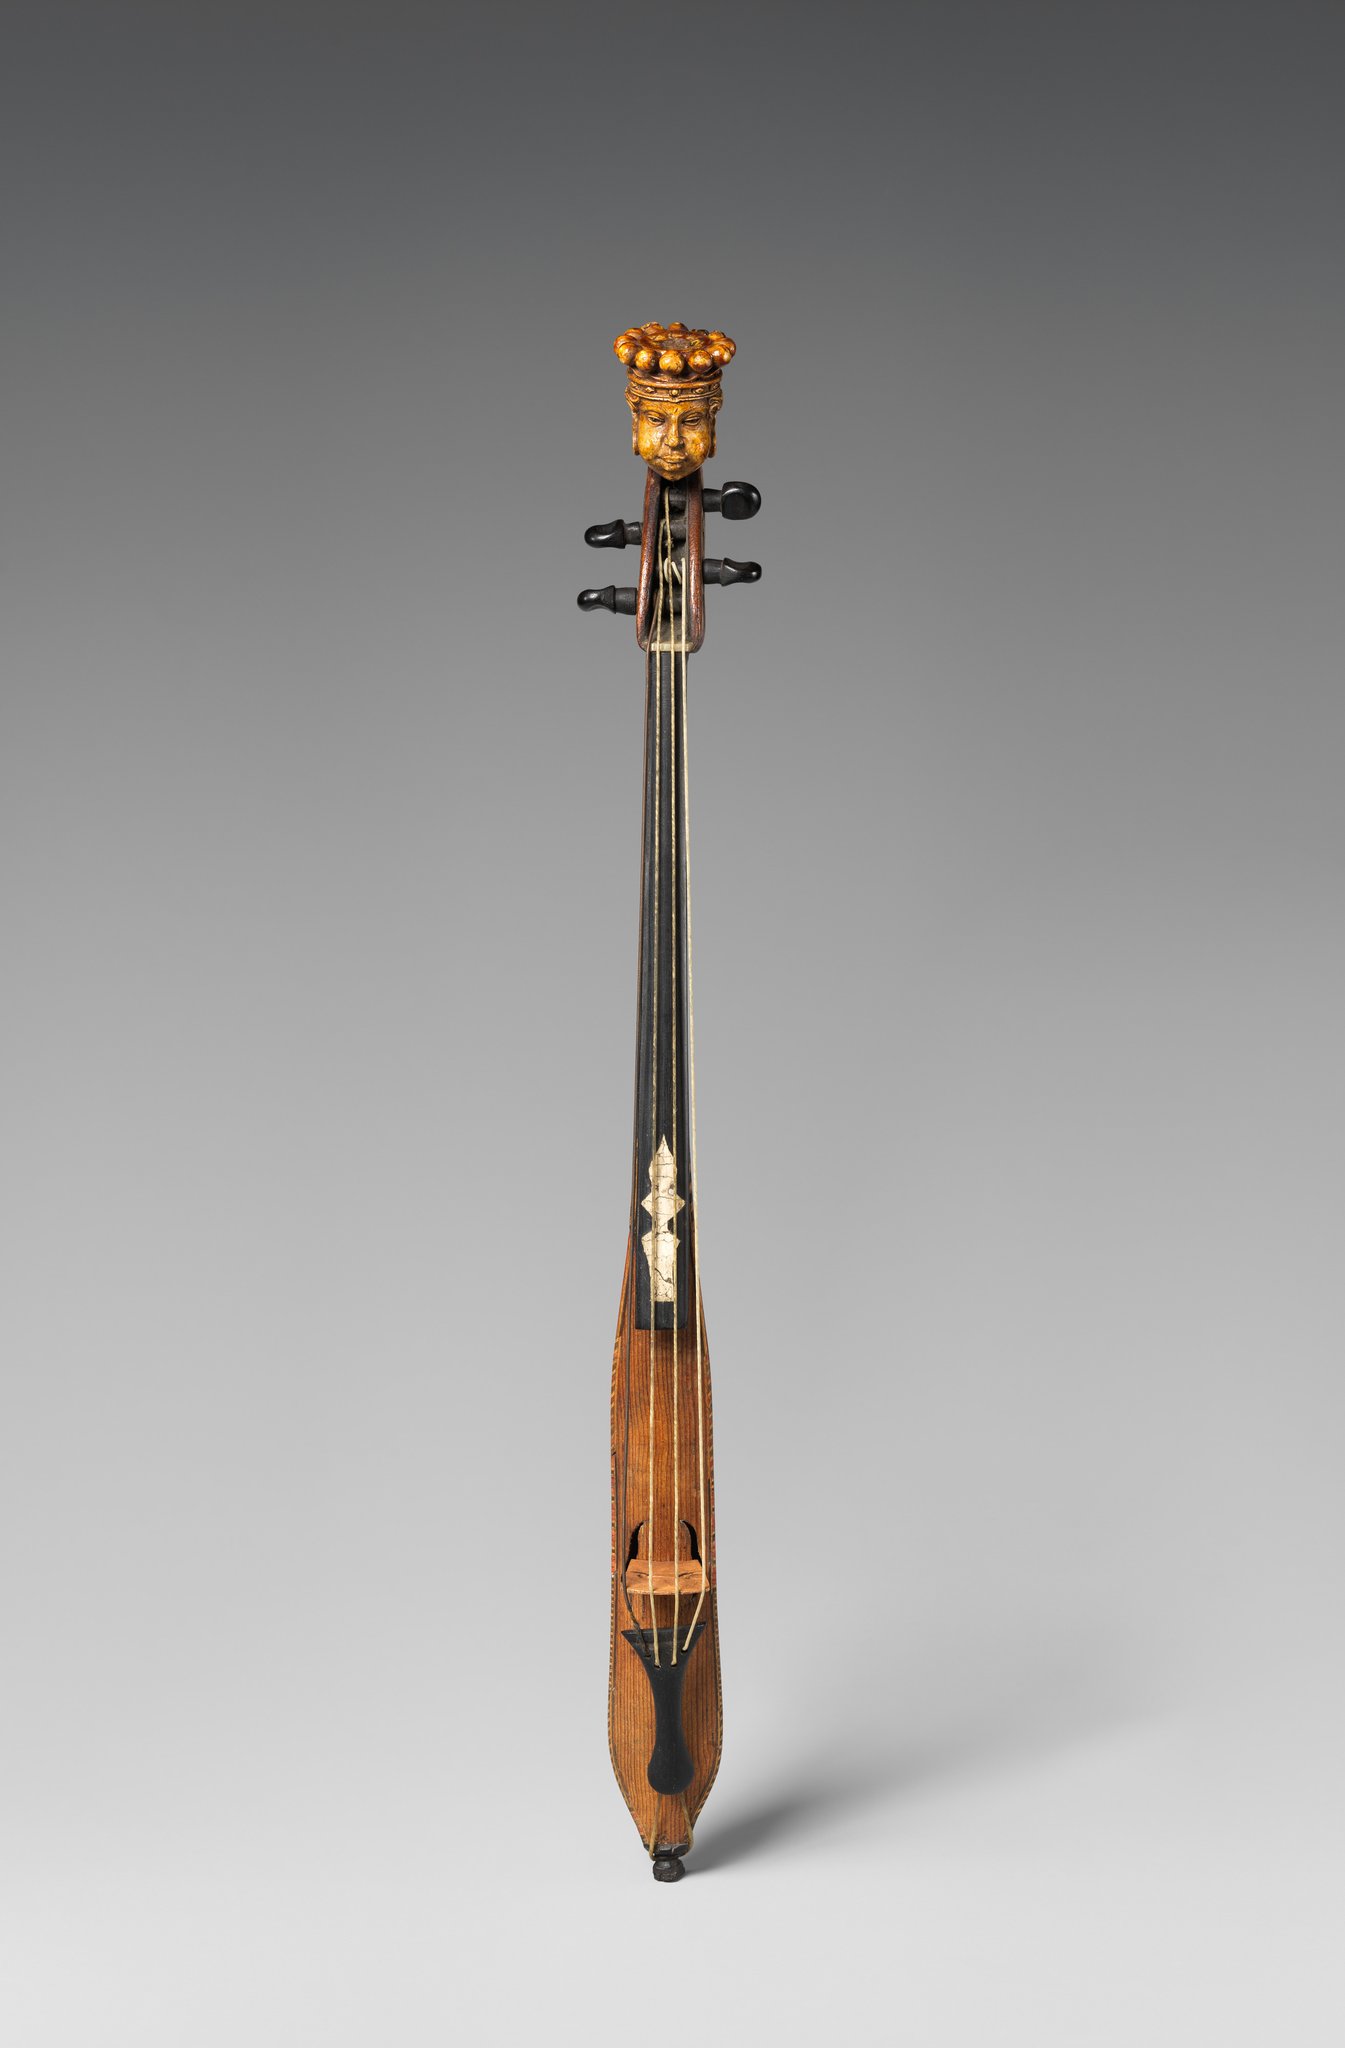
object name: pochette kit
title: Pochette (Kit)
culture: european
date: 1701-1800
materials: ivory, wood